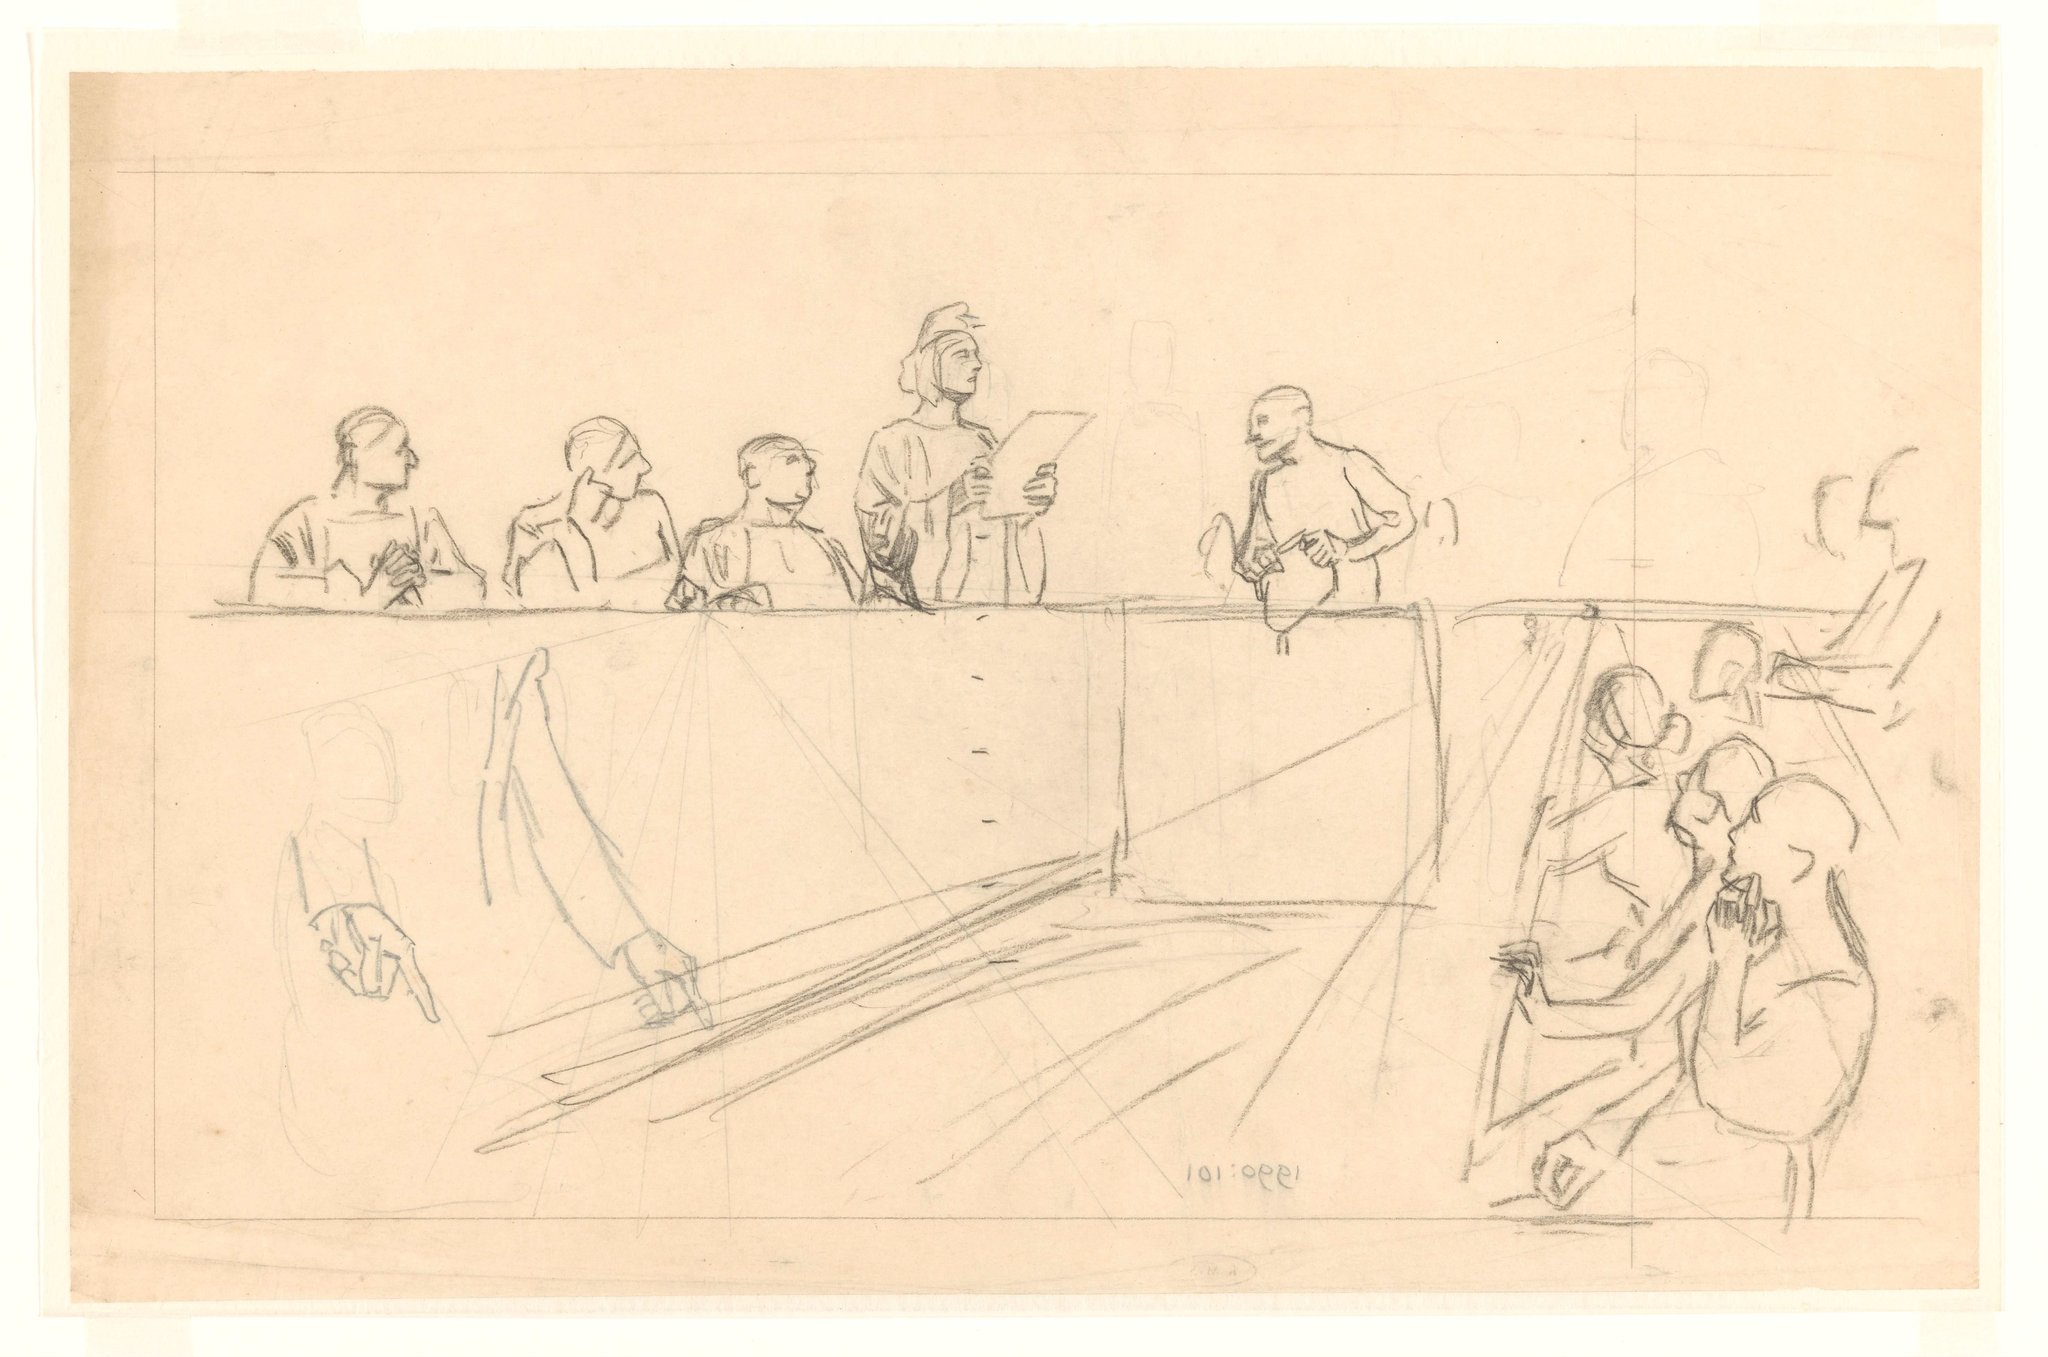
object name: design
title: Ontwerp voor illustratie in De Amsterdammer: een rechtzaal met een man in het beklaagdenbankje (14 Februari 1920)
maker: johan braakensiek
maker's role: draughtsman, print maker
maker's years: 1858-1940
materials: chalk, paper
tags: historical events and situations, political caricatures and satires